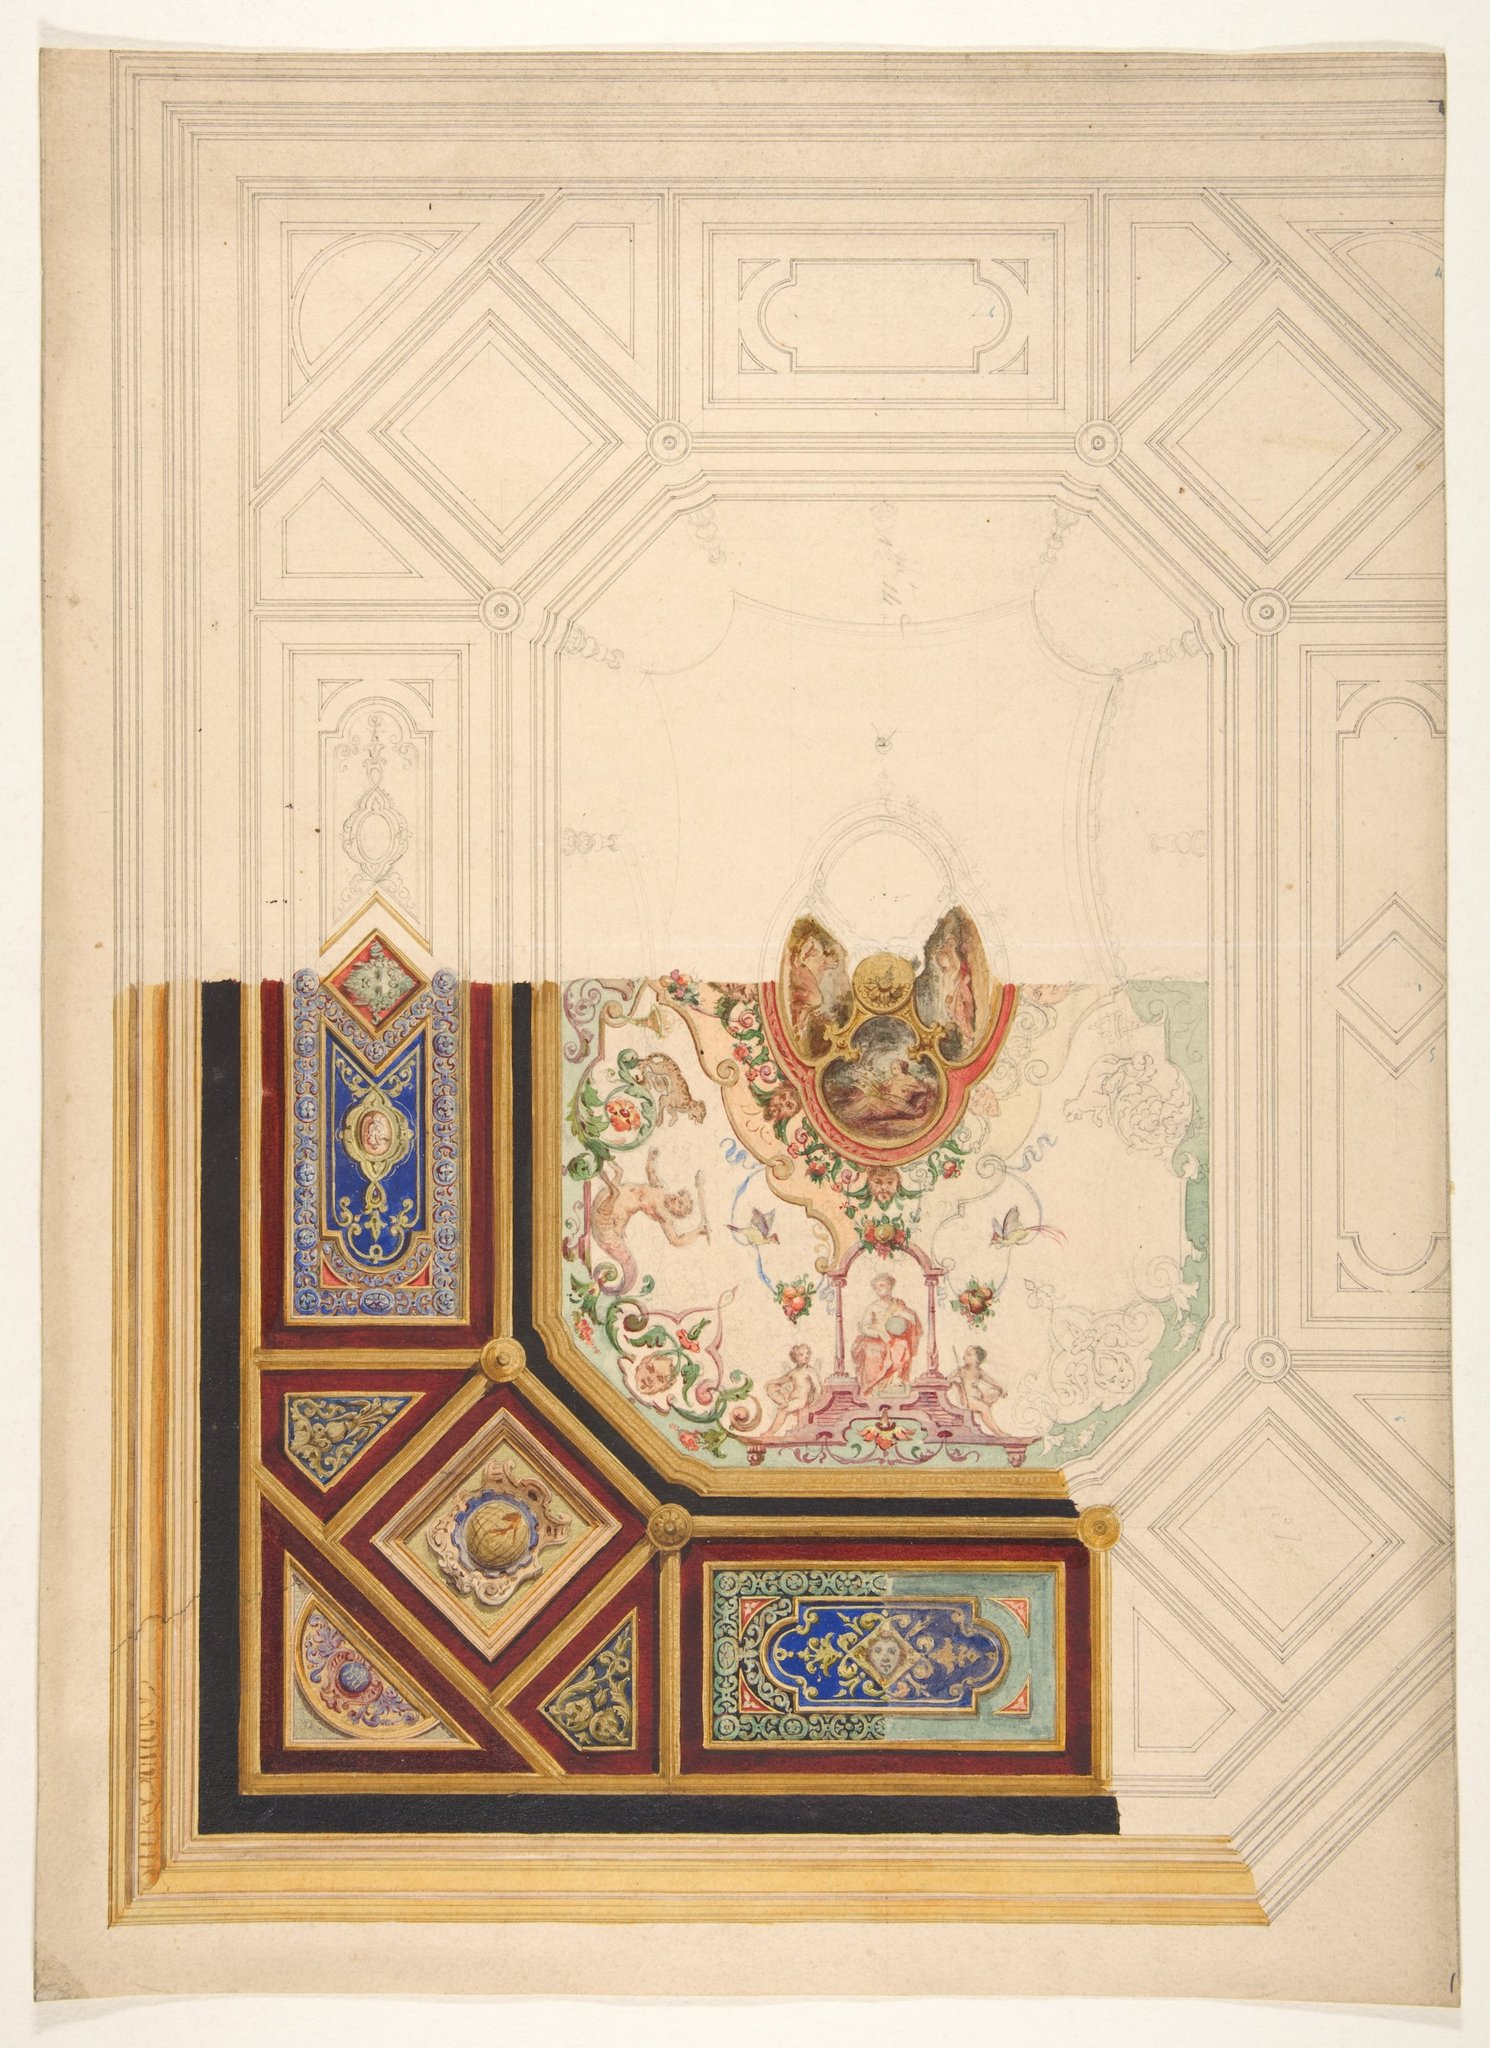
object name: drawing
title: Design for a paneled ceiling to be painted in grotesque motifs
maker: jules-edmond-charles lachaise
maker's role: artist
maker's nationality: french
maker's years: 1897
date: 1801-1900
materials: gouache, graphite, ink, watercolor, paper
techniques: pen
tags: grotesques,ornament